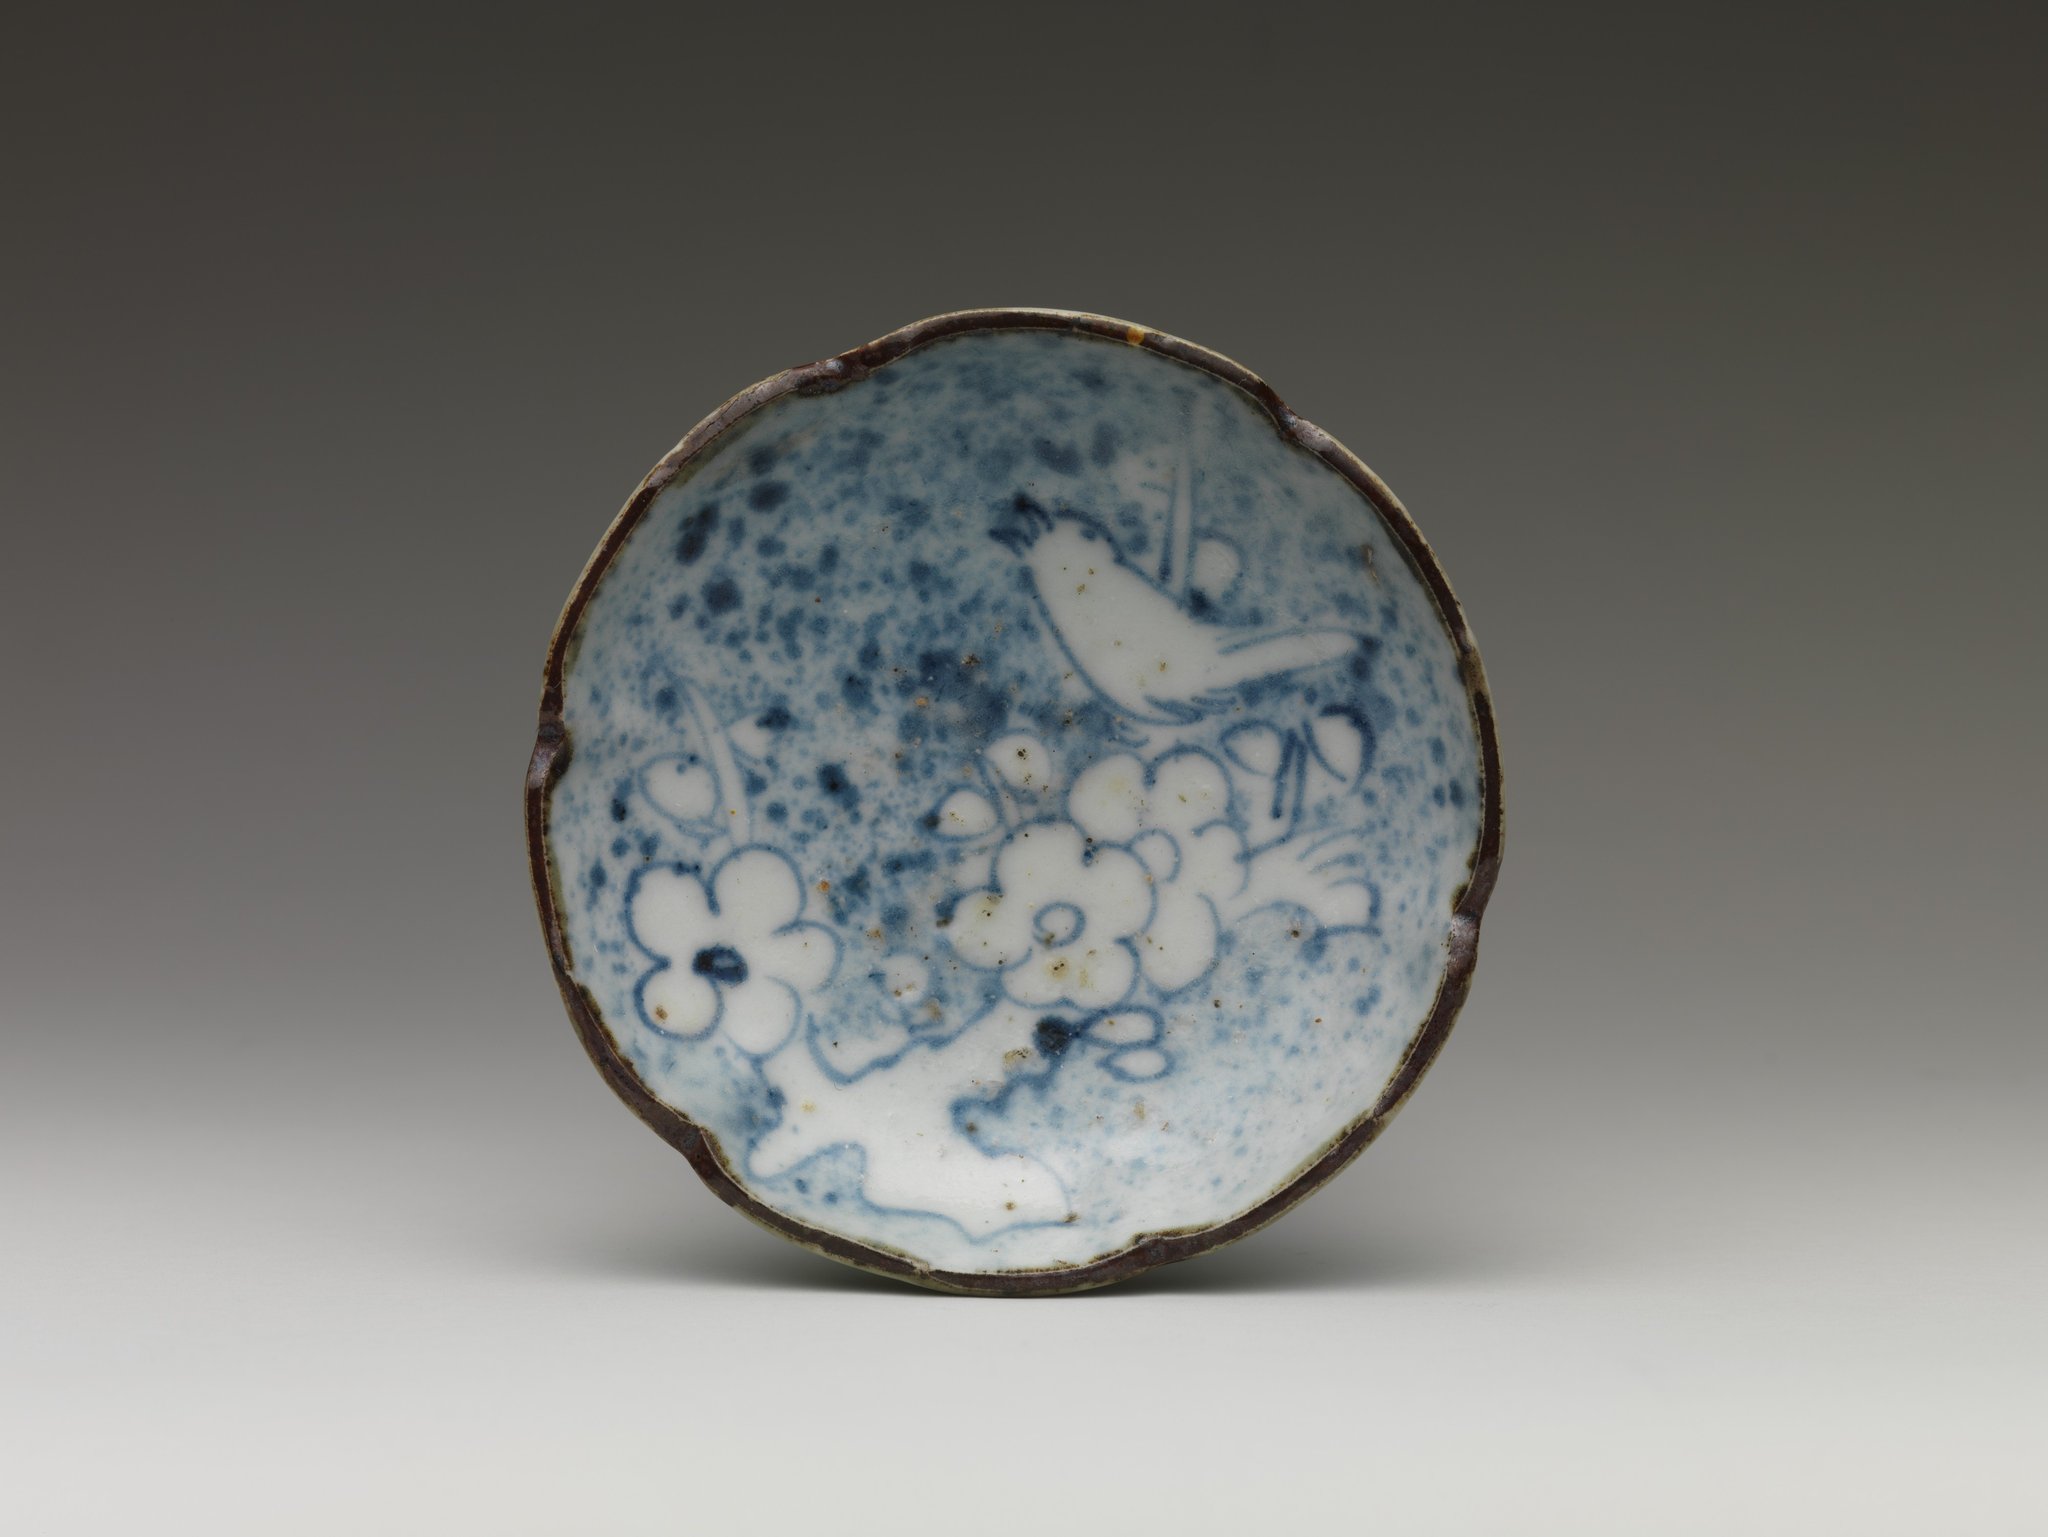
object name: dish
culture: japanese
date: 1640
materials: porcelain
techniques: underglaze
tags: birds